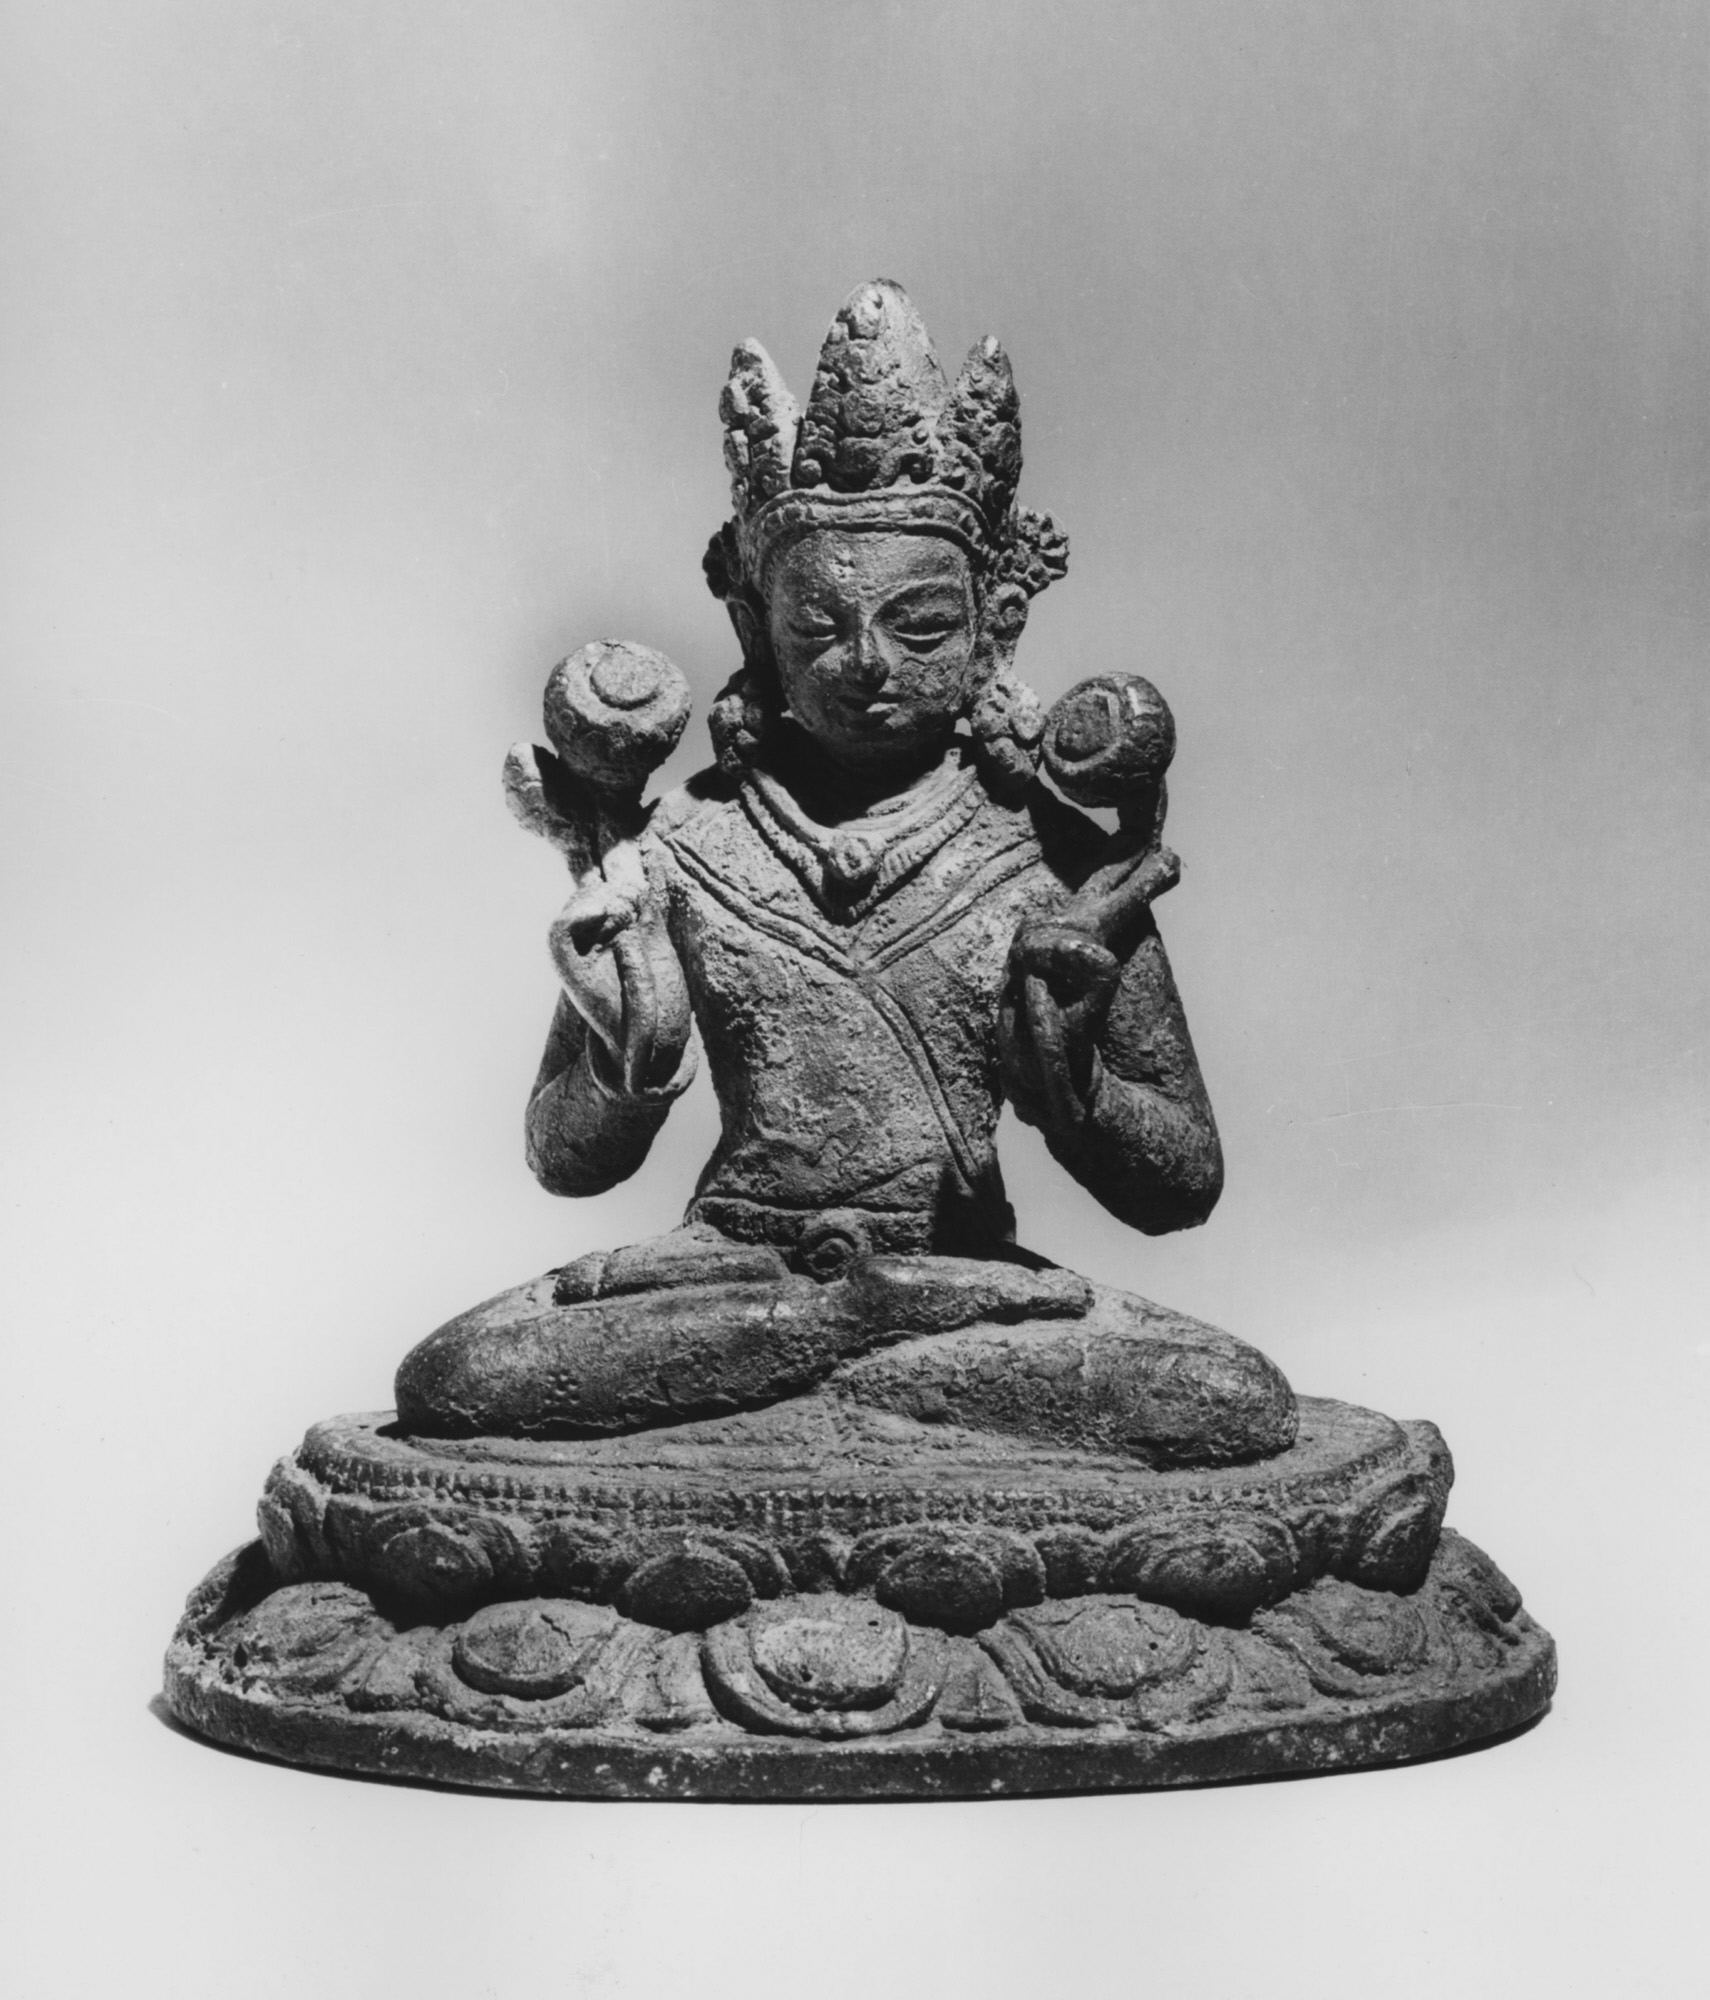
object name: figure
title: Seated Surya (God of the Sun)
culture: nepali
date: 801-900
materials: copper alloy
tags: hinduism